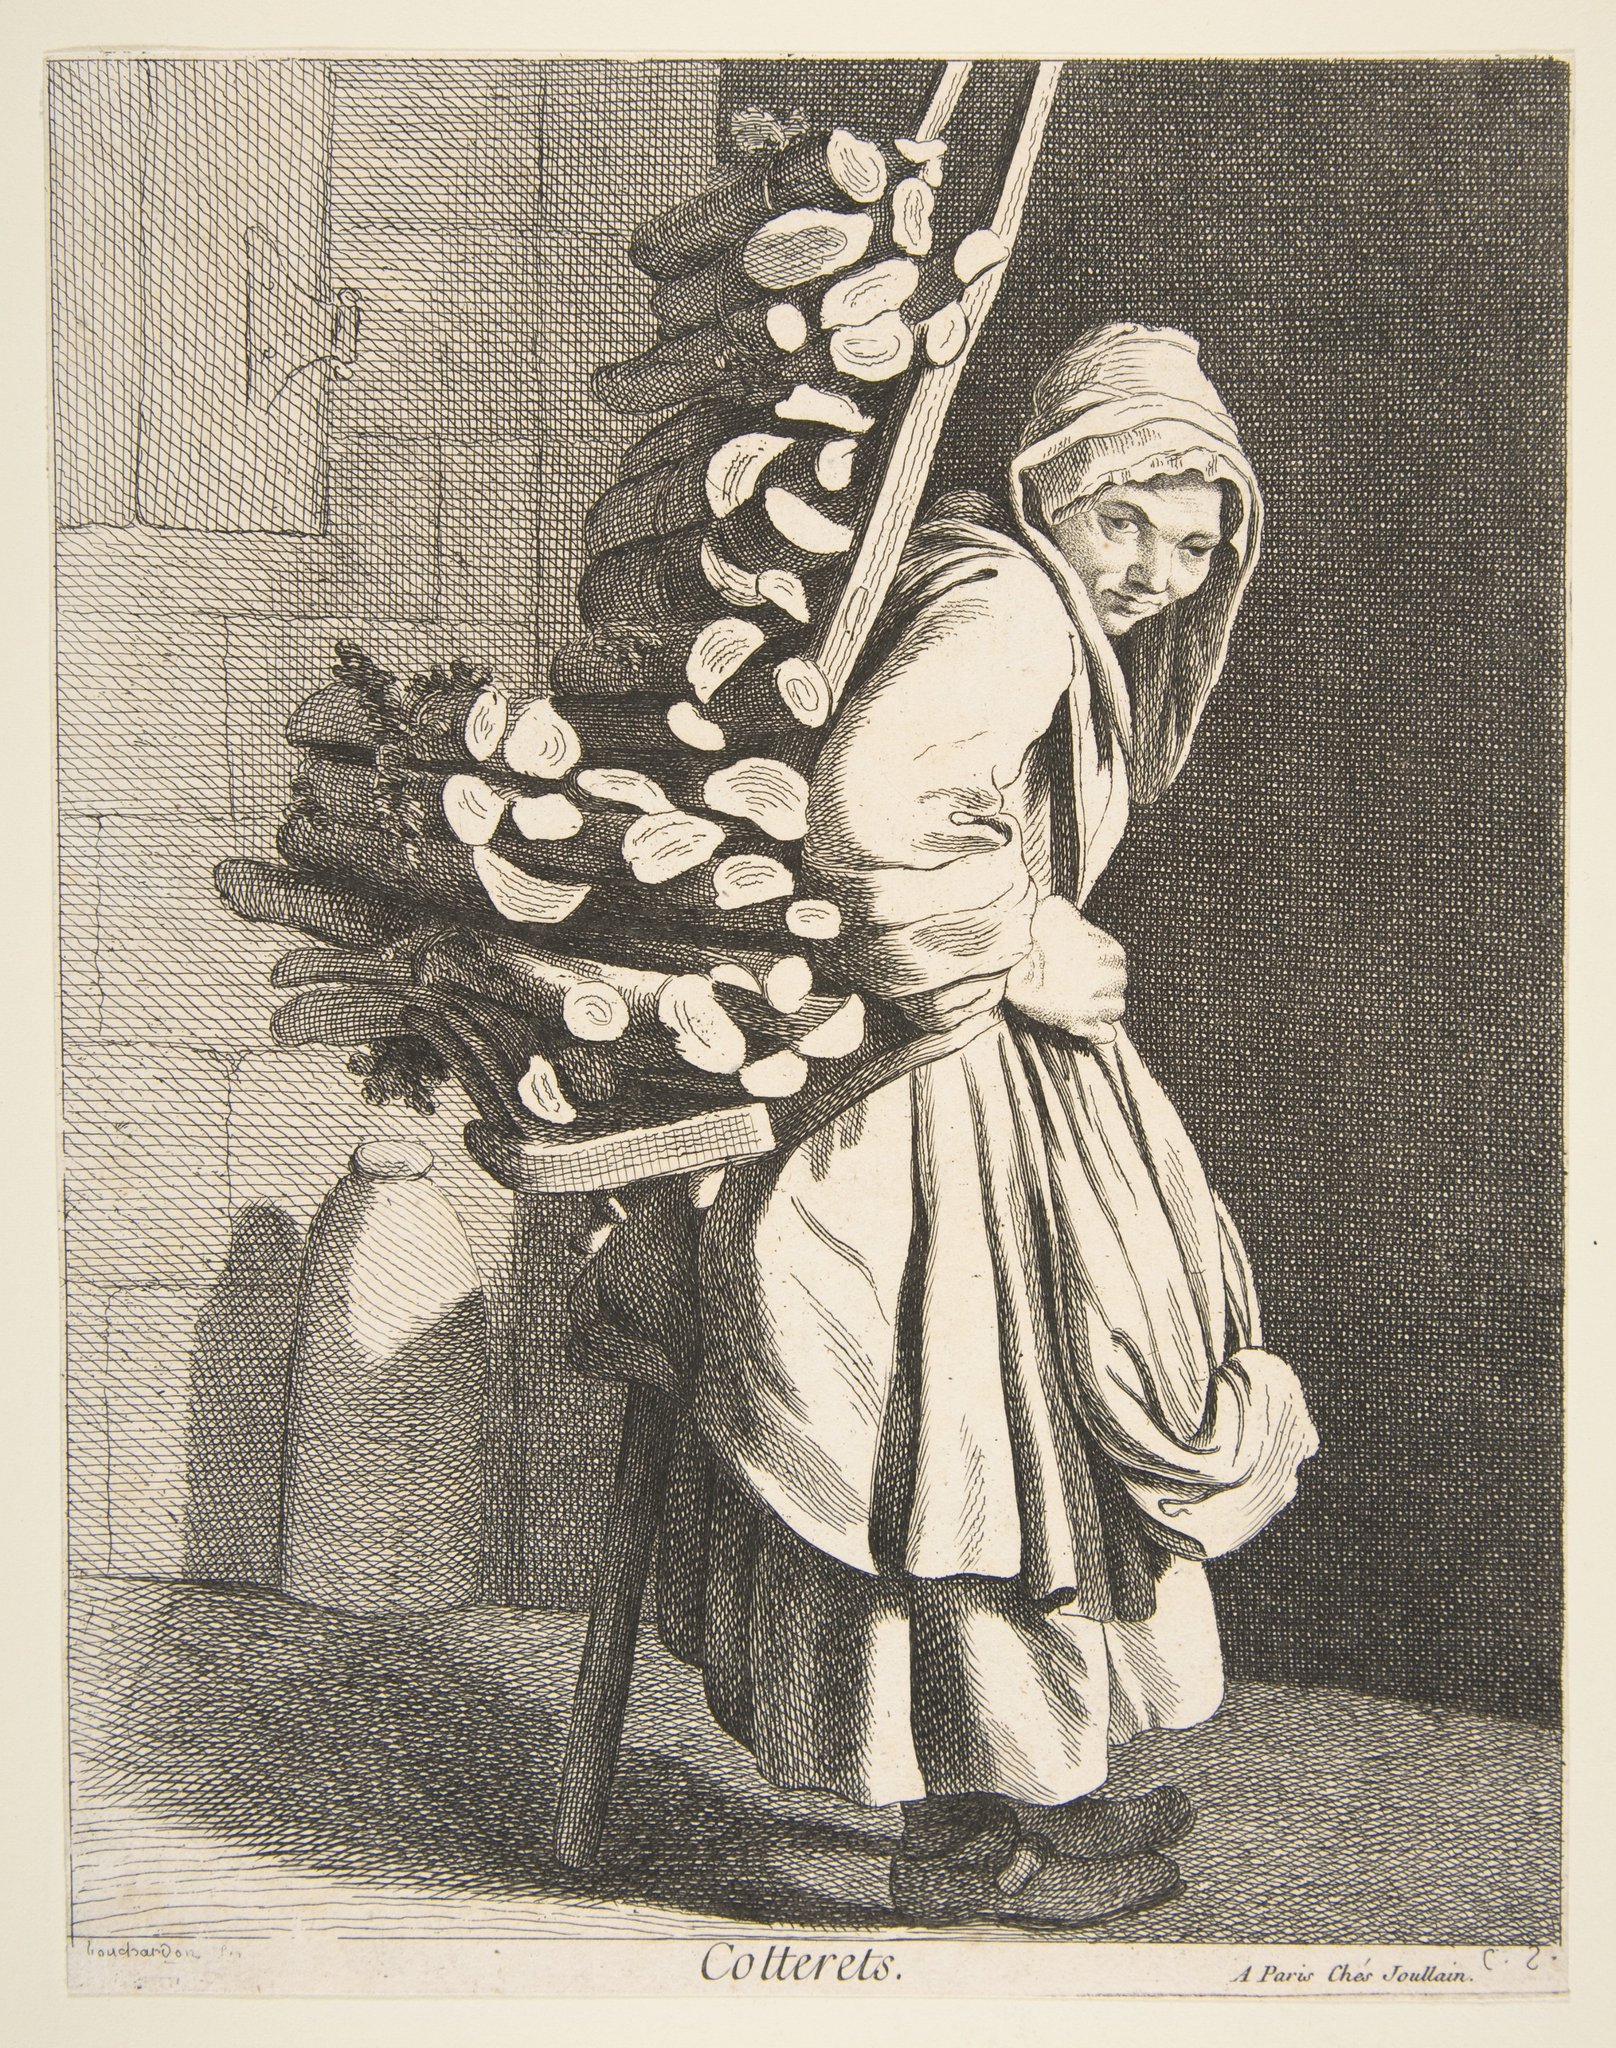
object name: print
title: Bundled Firewood Seller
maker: anne claude philippe de tubières, comte de caylus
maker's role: artist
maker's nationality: french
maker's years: 1692-1765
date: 1746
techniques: engraving, etching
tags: women